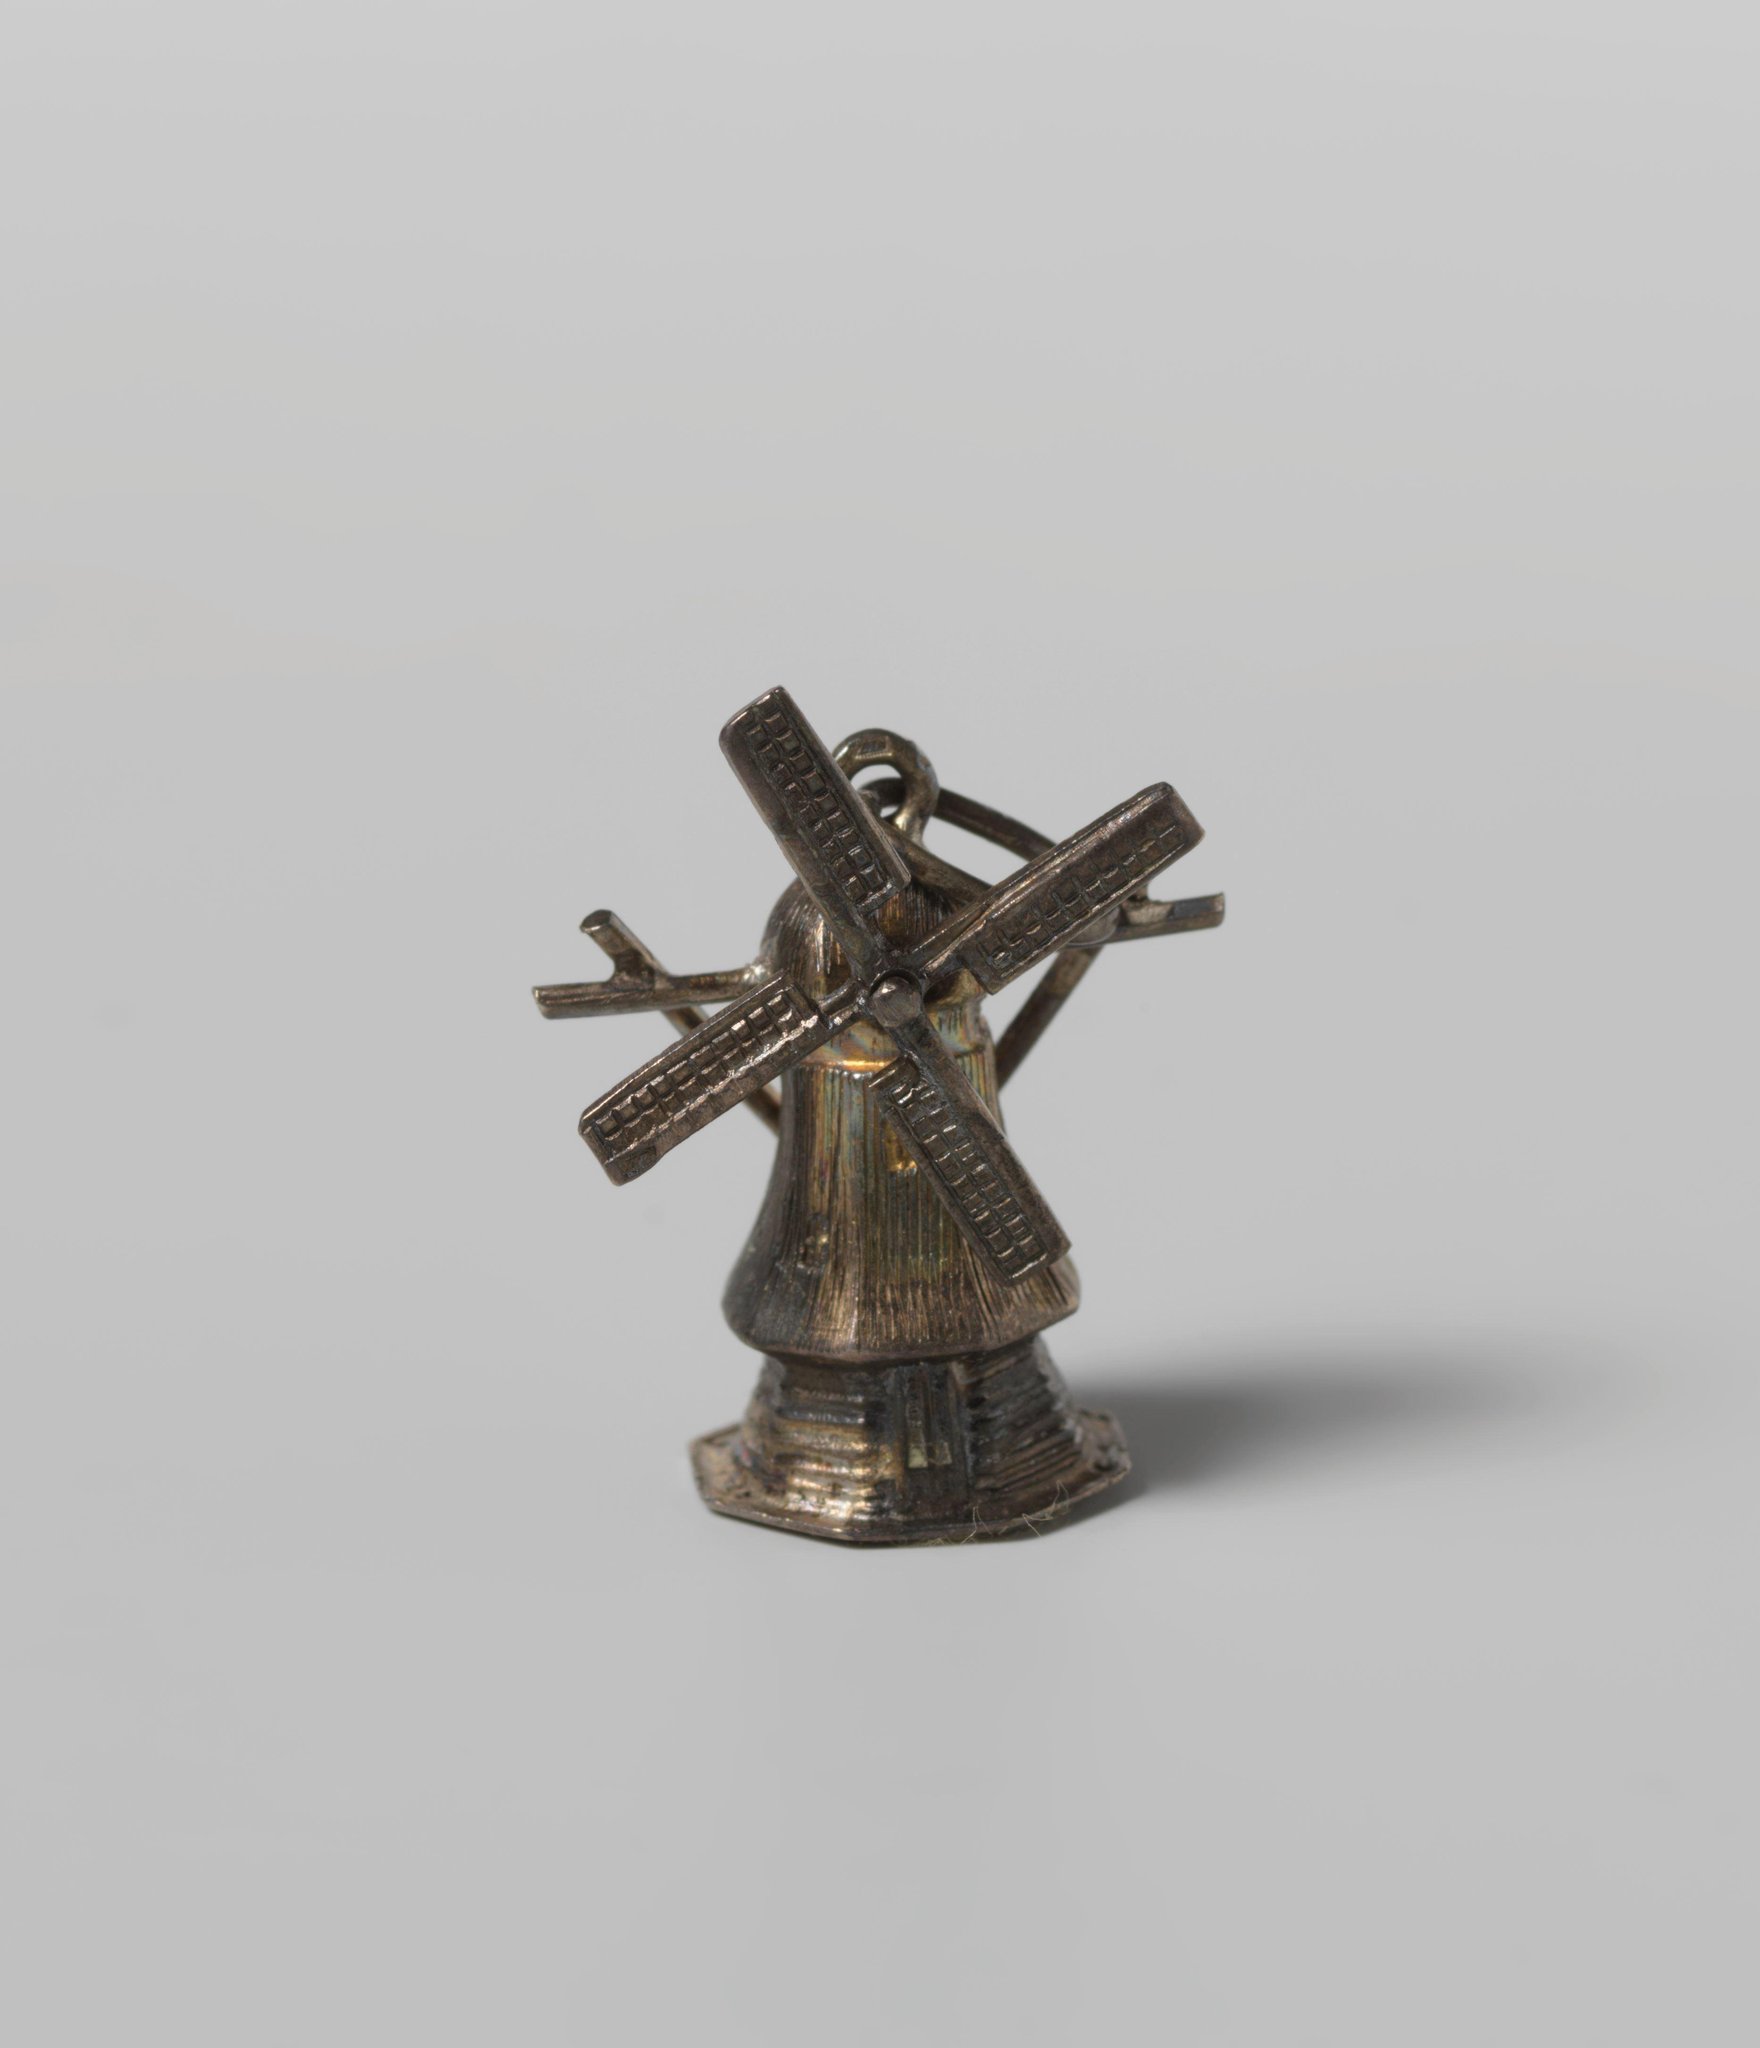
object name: charm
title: Bedel van zilver van een molen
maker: g. foreman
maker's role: jeweler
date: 1953-1970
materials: silver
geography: maarn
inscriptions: import mark: ‘G+F’, alloy mark: ‘Z2’